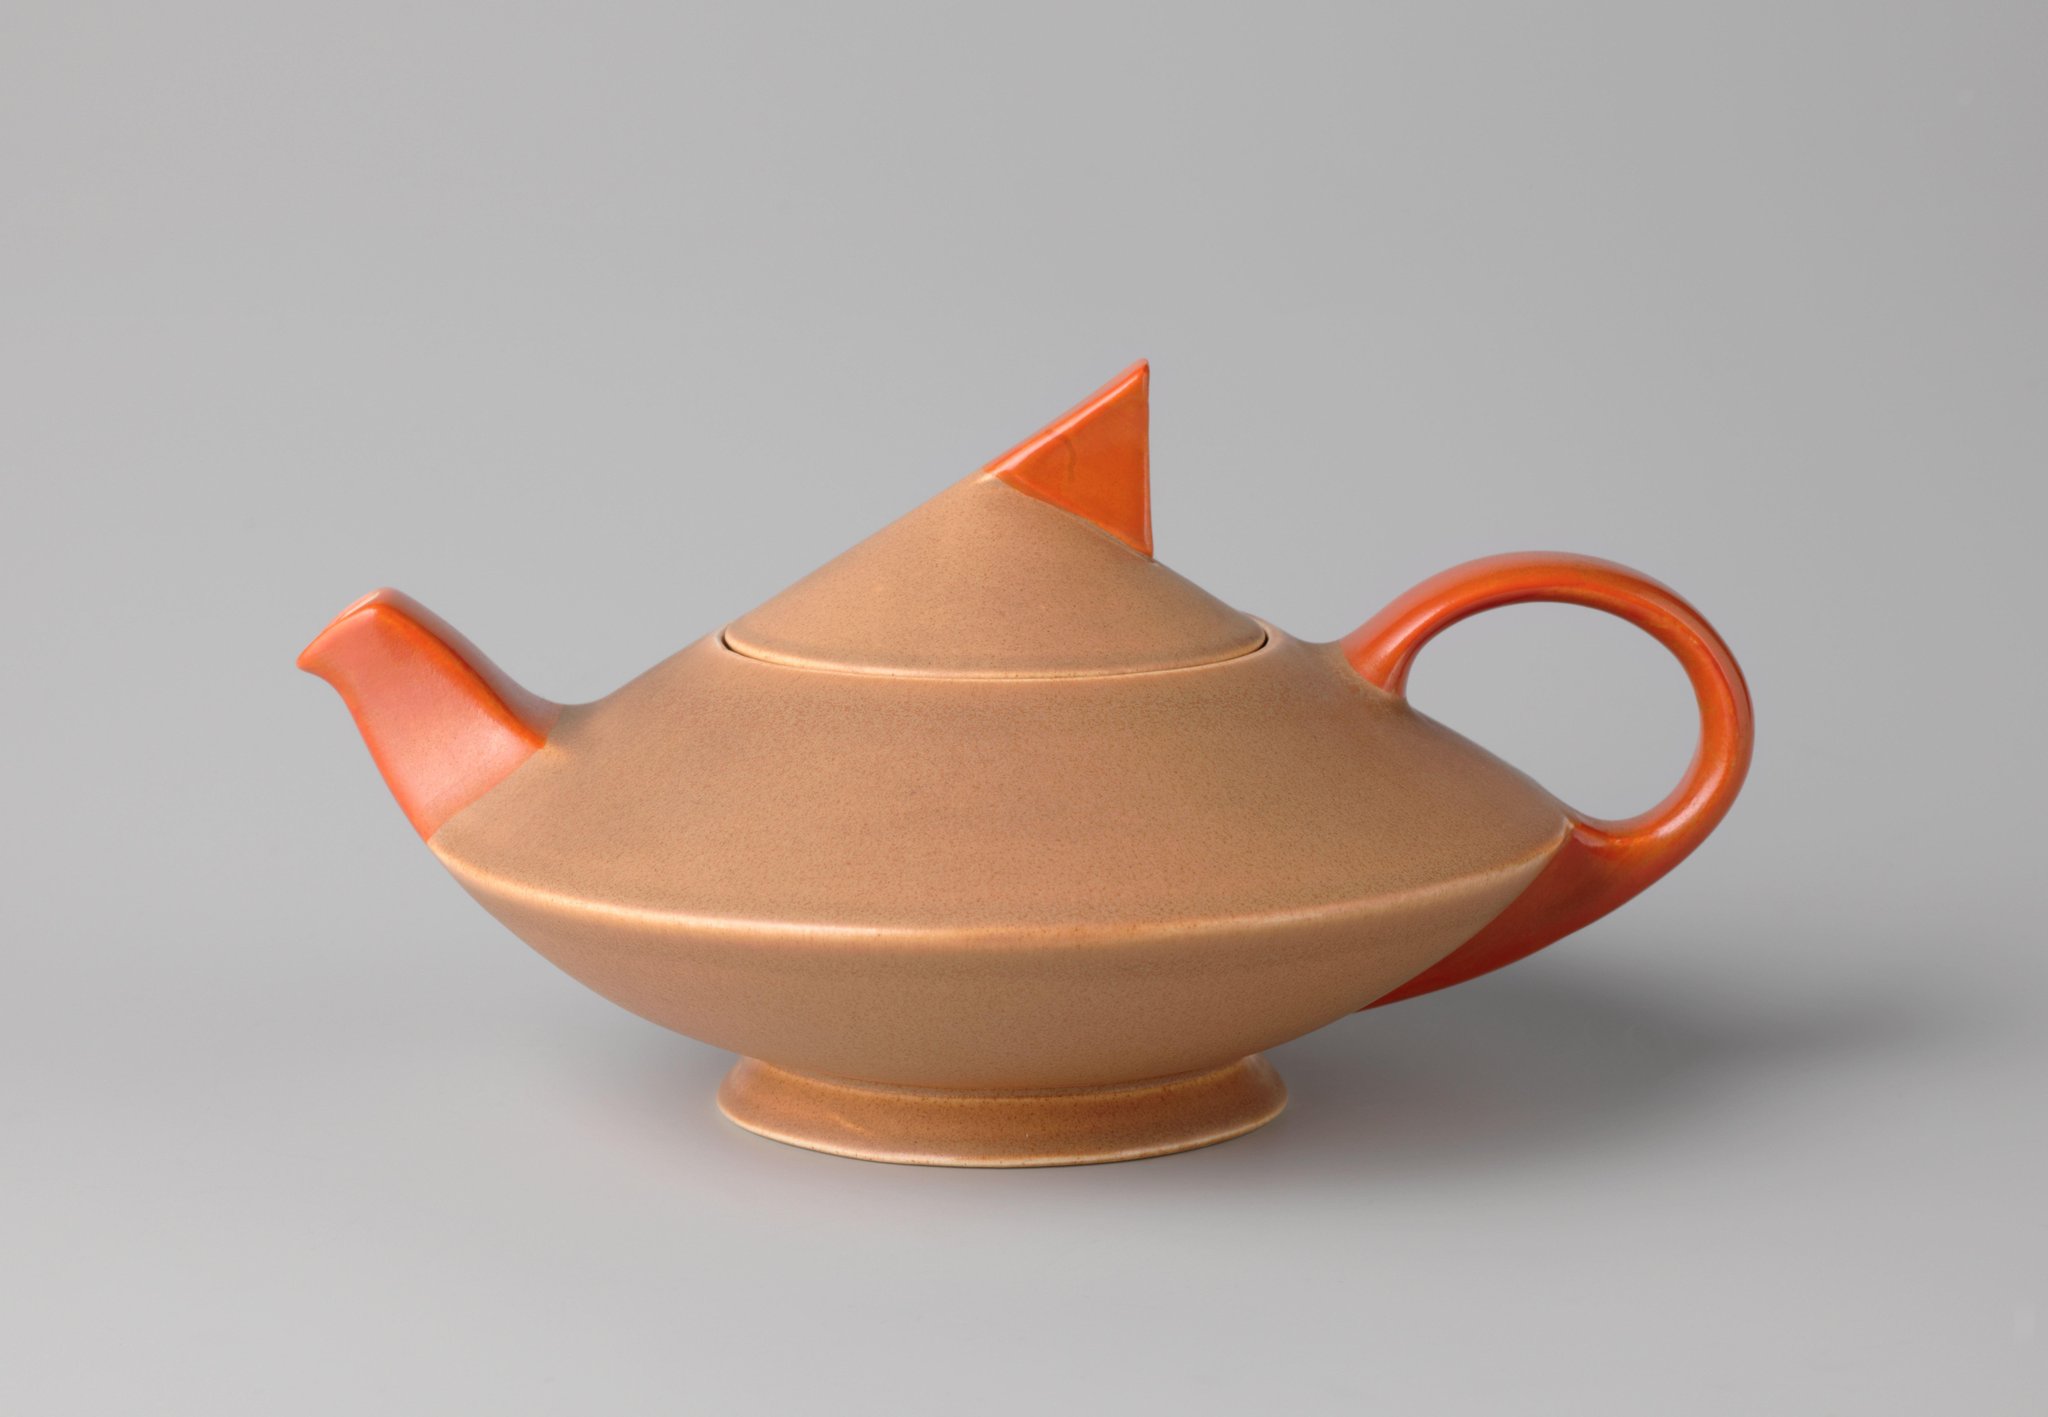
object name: teapot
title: Theepot, deel van een theeservies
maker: edmond bellefroid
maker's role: ceramicist, painter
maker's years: 1893-1971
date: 1934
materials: earthenware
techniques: painted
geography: maastricht